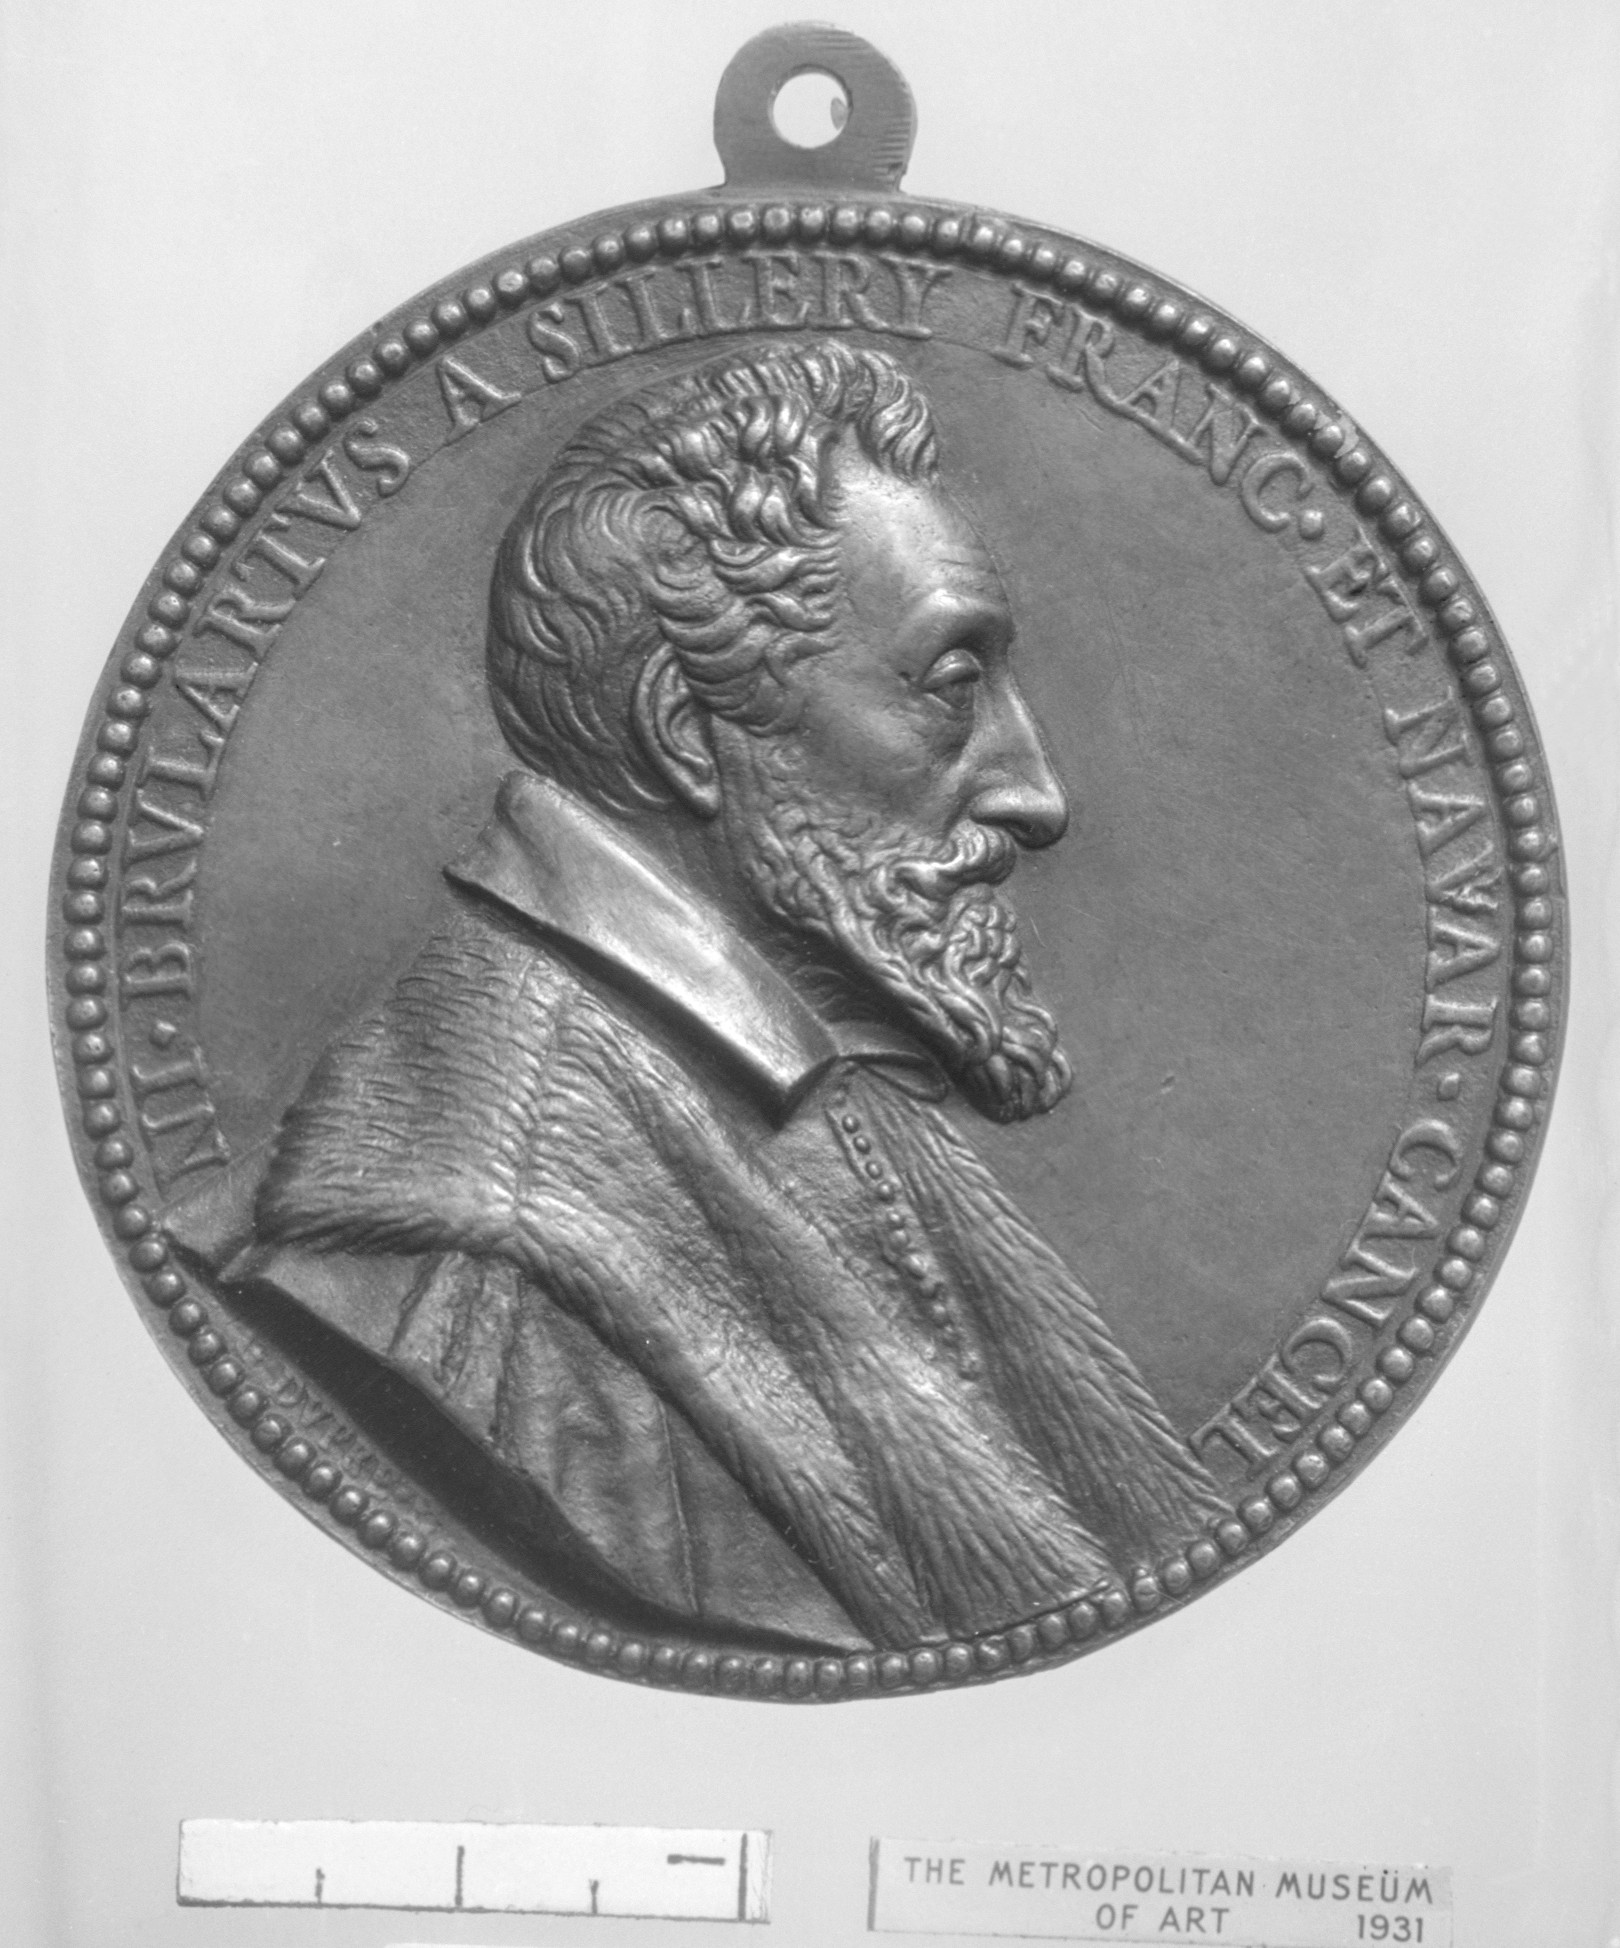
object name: medal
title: Nicolas Brulart de Sillery, Chancellor of France (1544?–1624, Chancellor of France 1607)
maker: guillaume dupré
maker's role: artist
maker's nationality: french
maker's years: 1579-1640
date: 1613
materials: bronze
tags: men,profiles,horses,lions,medals,chariots